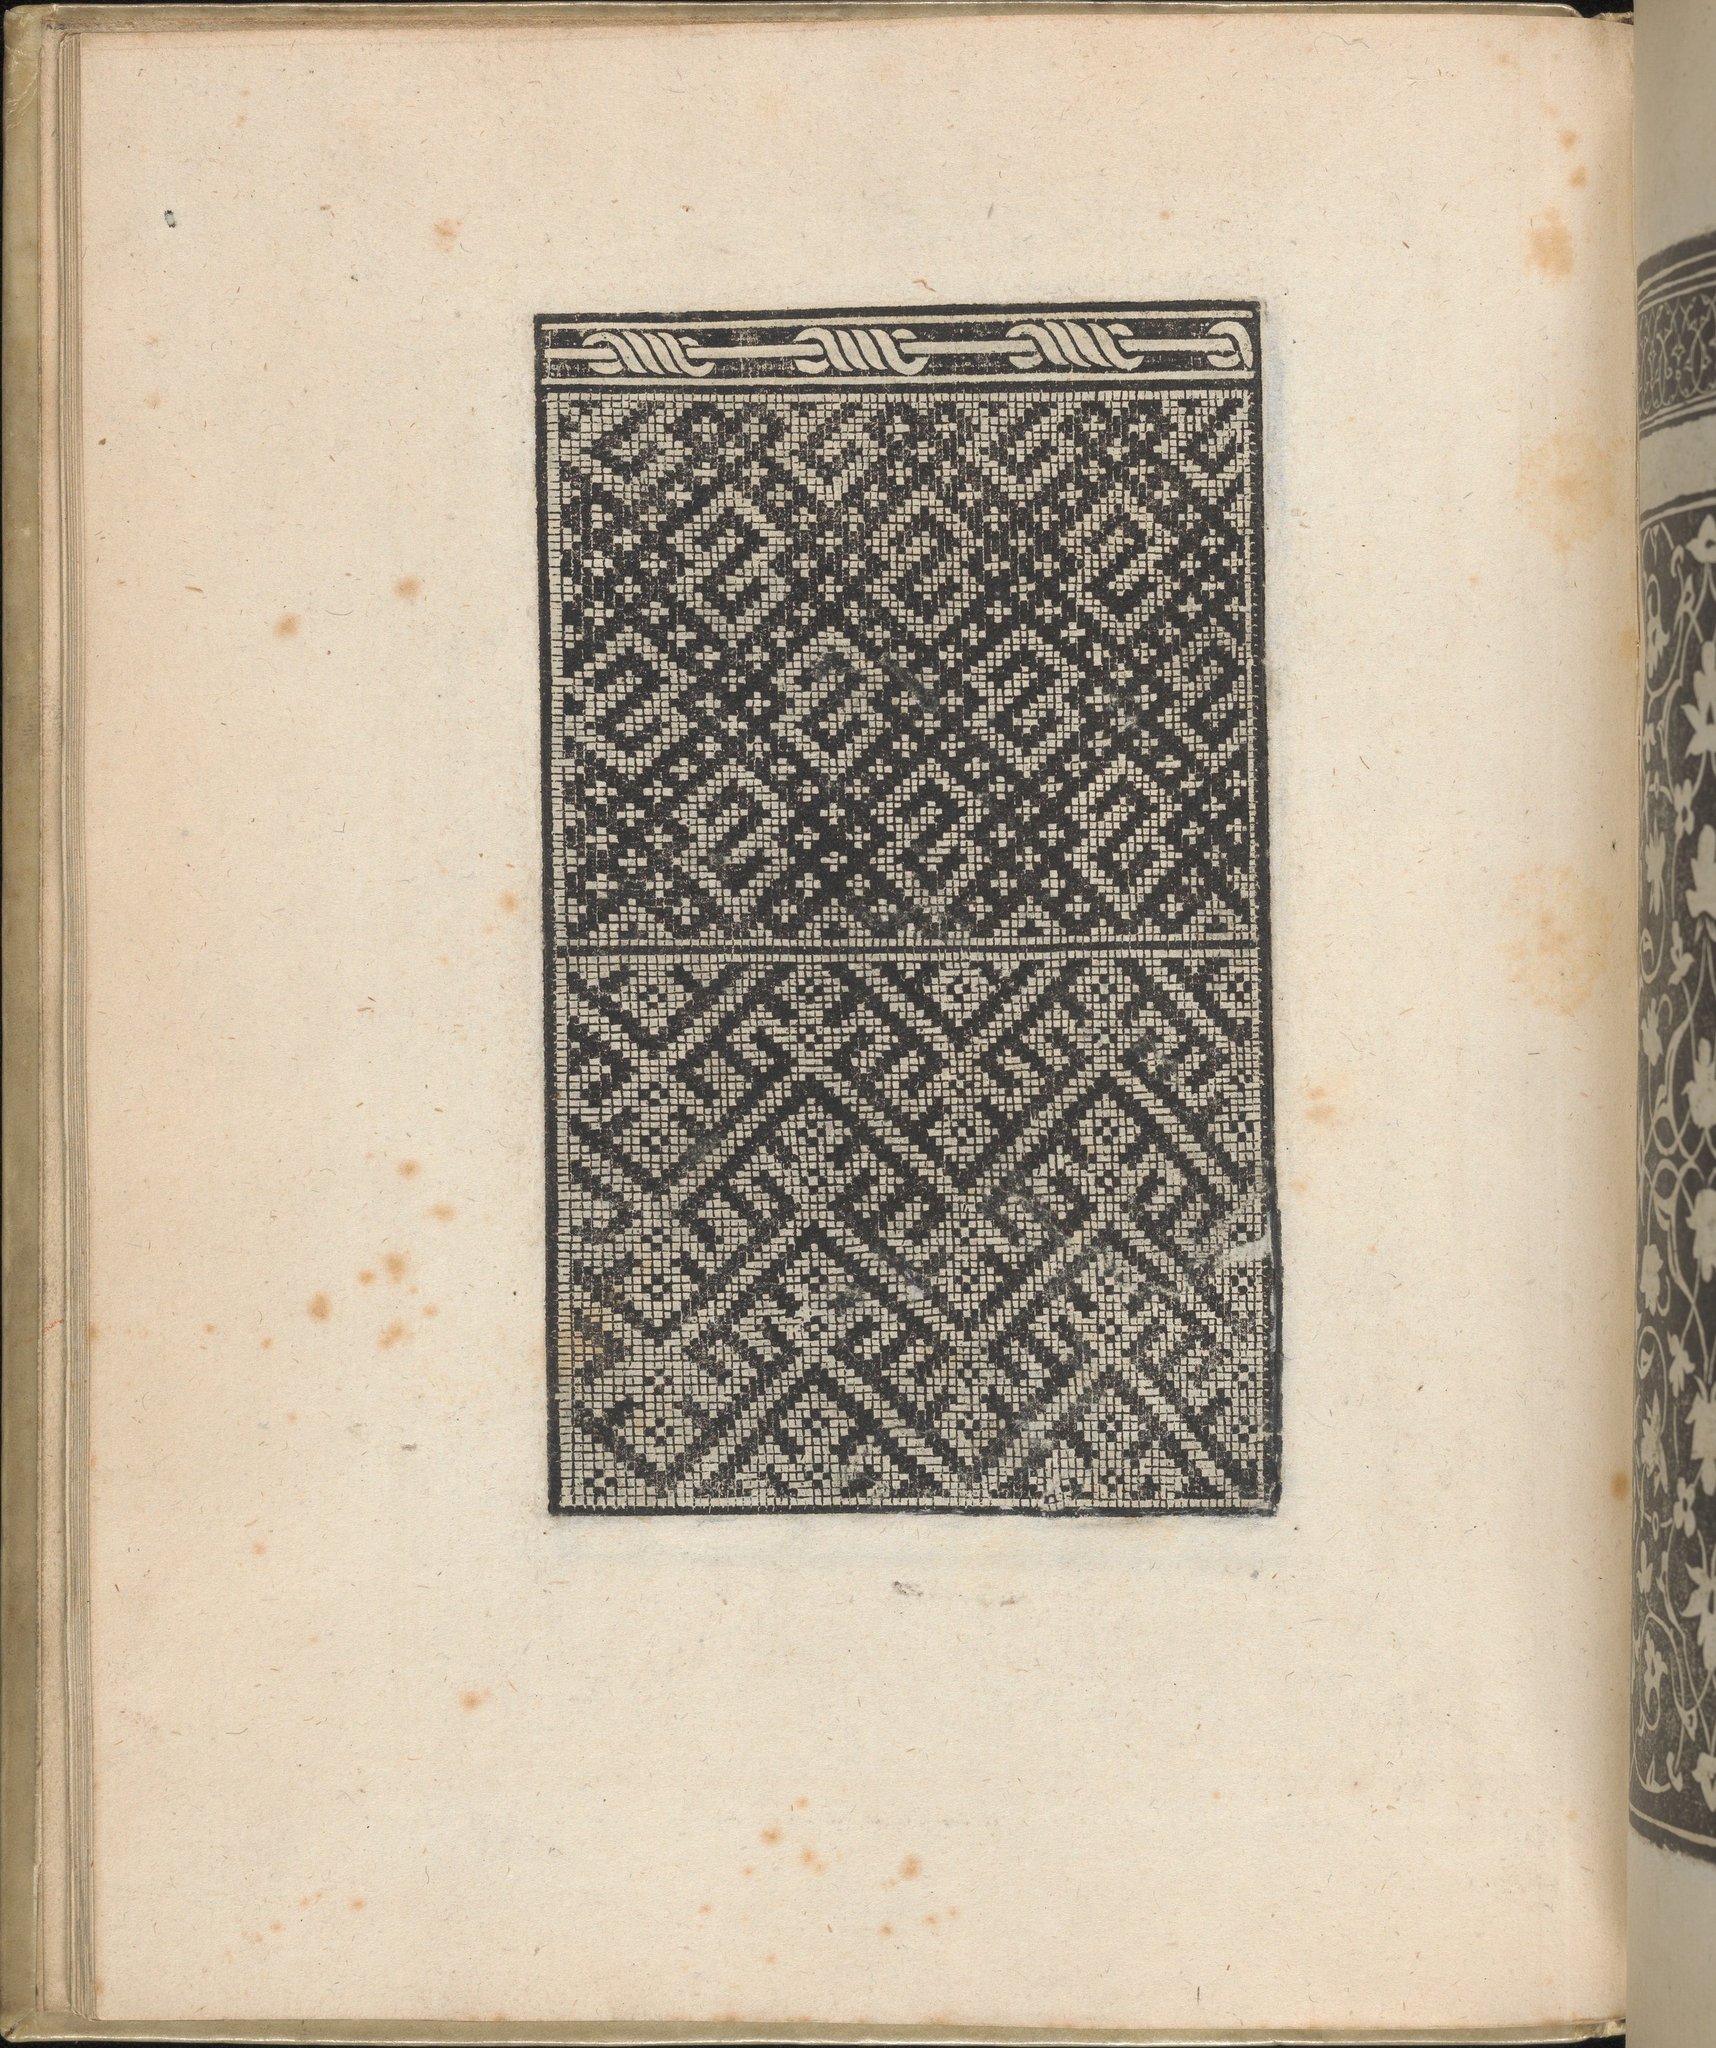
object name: book print ornament architecture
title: Trionfo Di Virtu. Libro Novo..., page 11 (verso)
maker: matteo pagano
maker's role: publisher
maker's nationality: italian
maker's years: 1515-1588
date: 1563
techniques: woodcut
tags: ornament